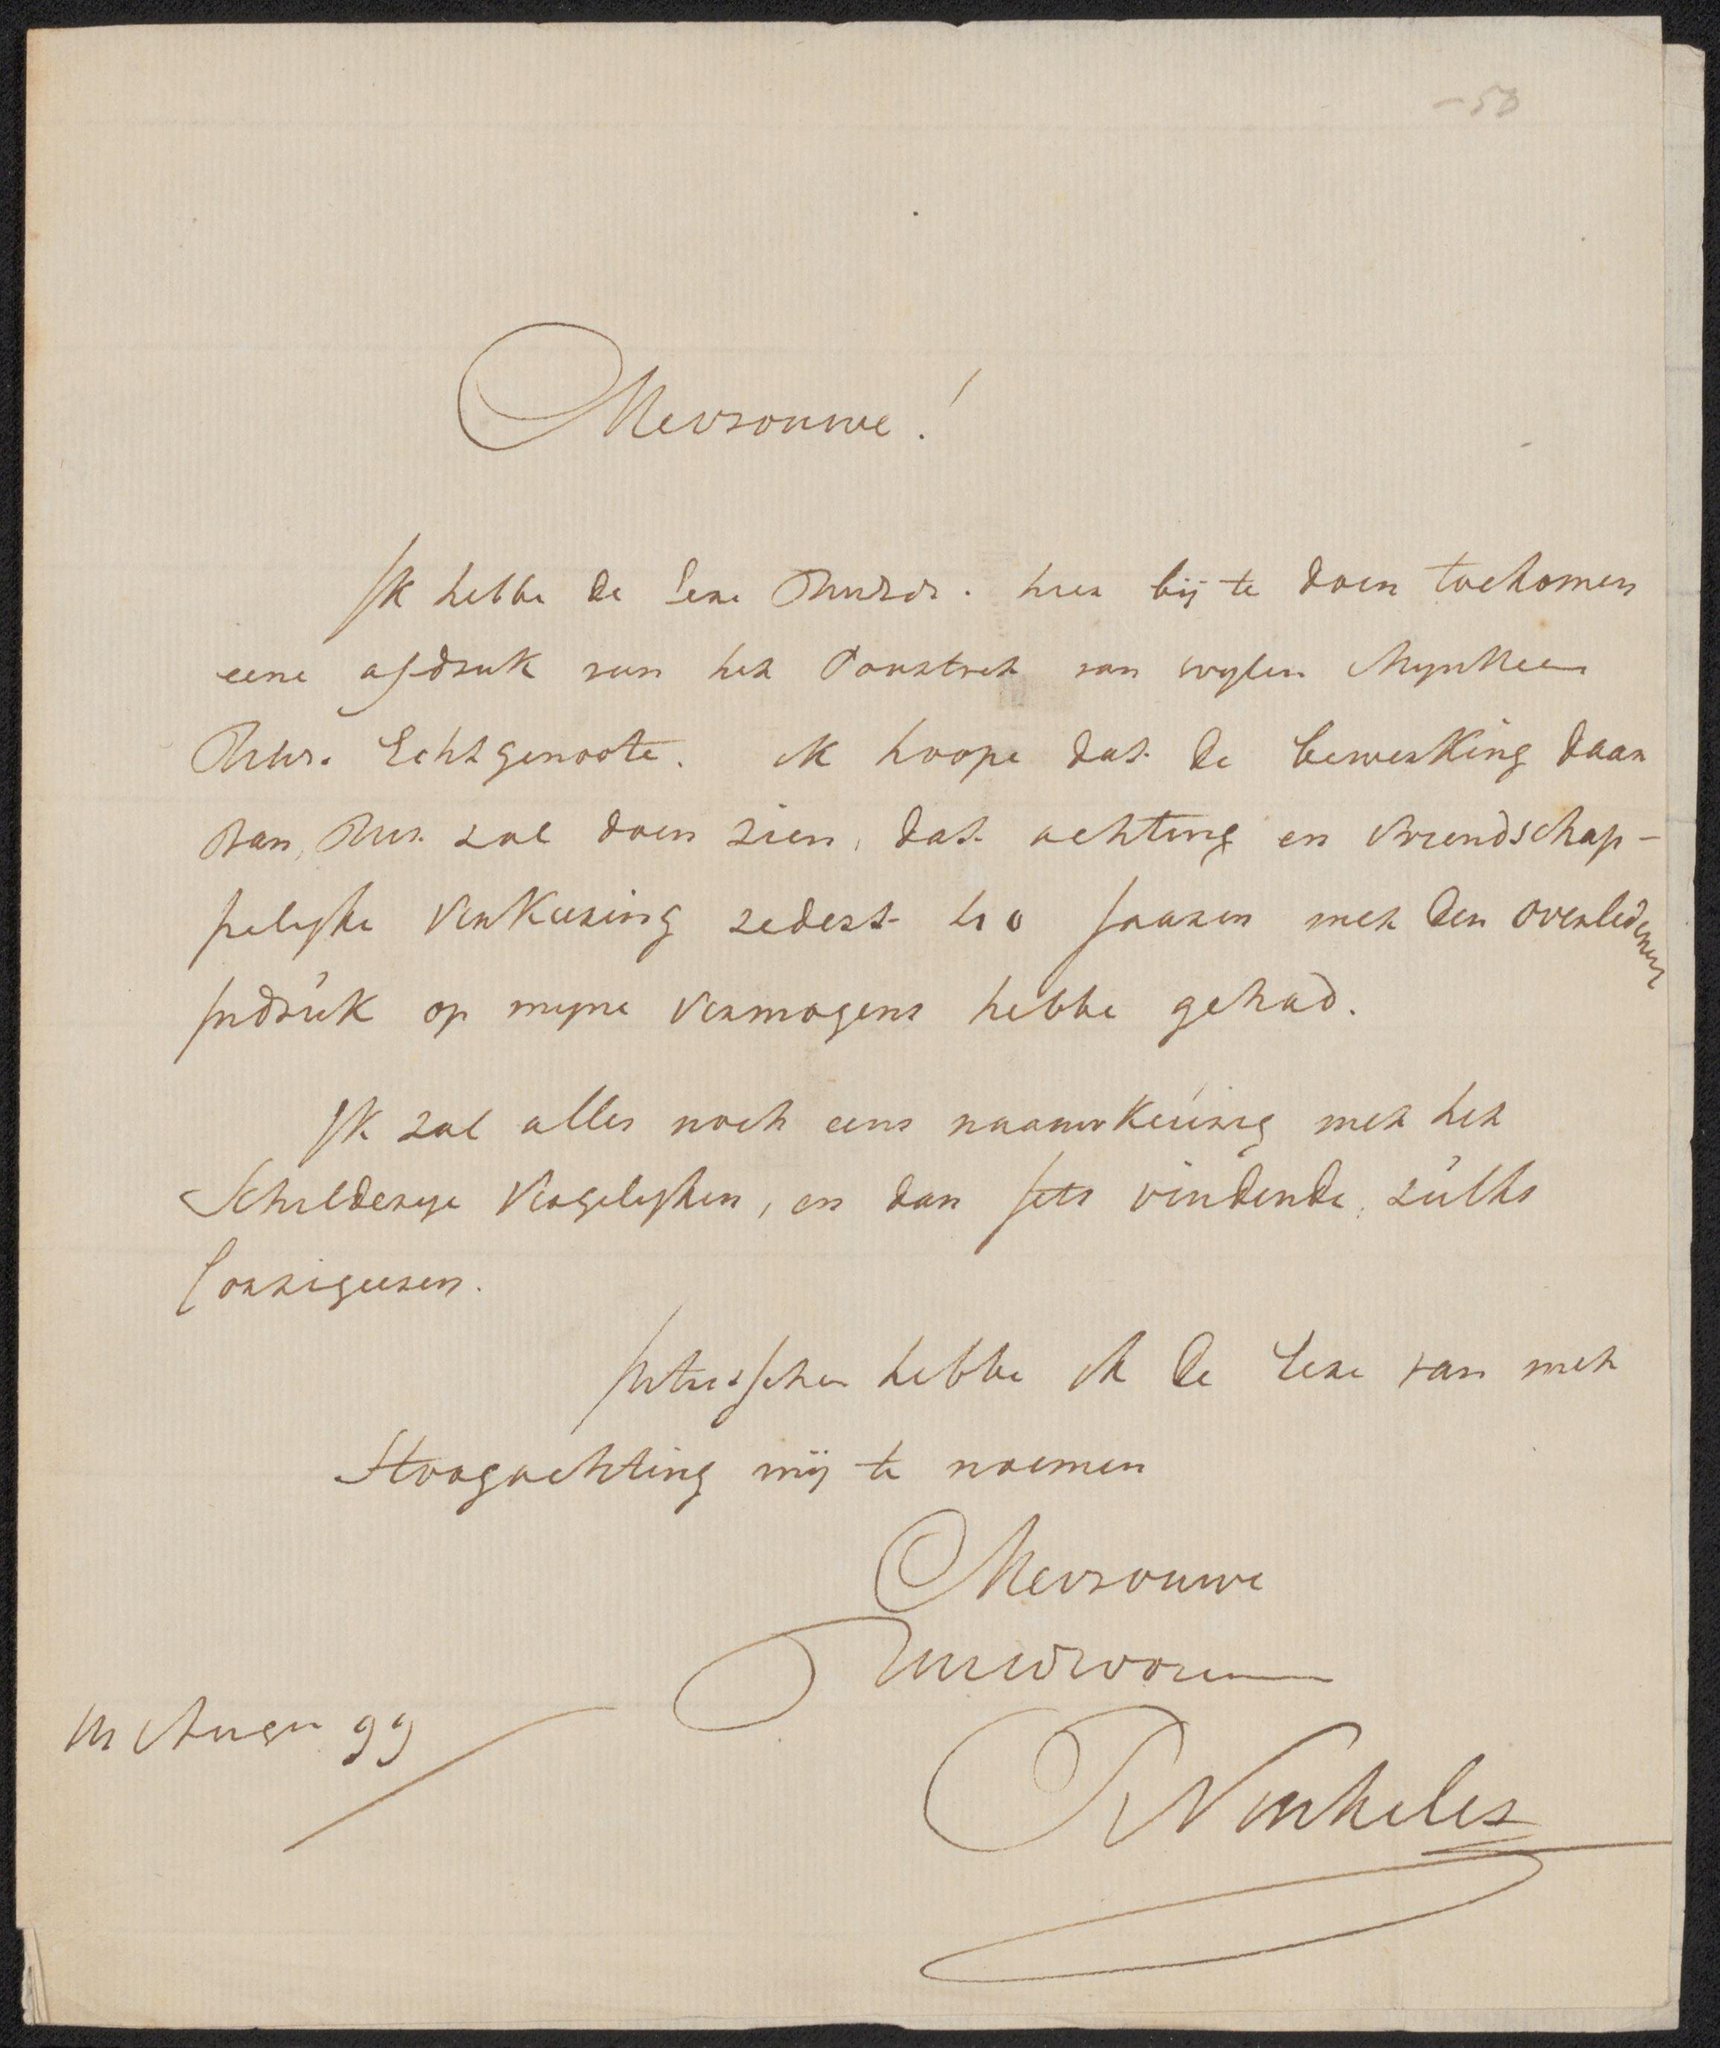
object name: letter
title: Brief aan anoniem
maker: reinier vinkeles (i)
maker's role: draughtsman, print maker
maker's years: 1741-1816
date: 1799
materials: ink, paper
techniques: pen, writing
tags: the graphic arts, painting (including book-illumination, miniature-painting), historical persons (portraits and scenes from the life)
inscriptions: watermark